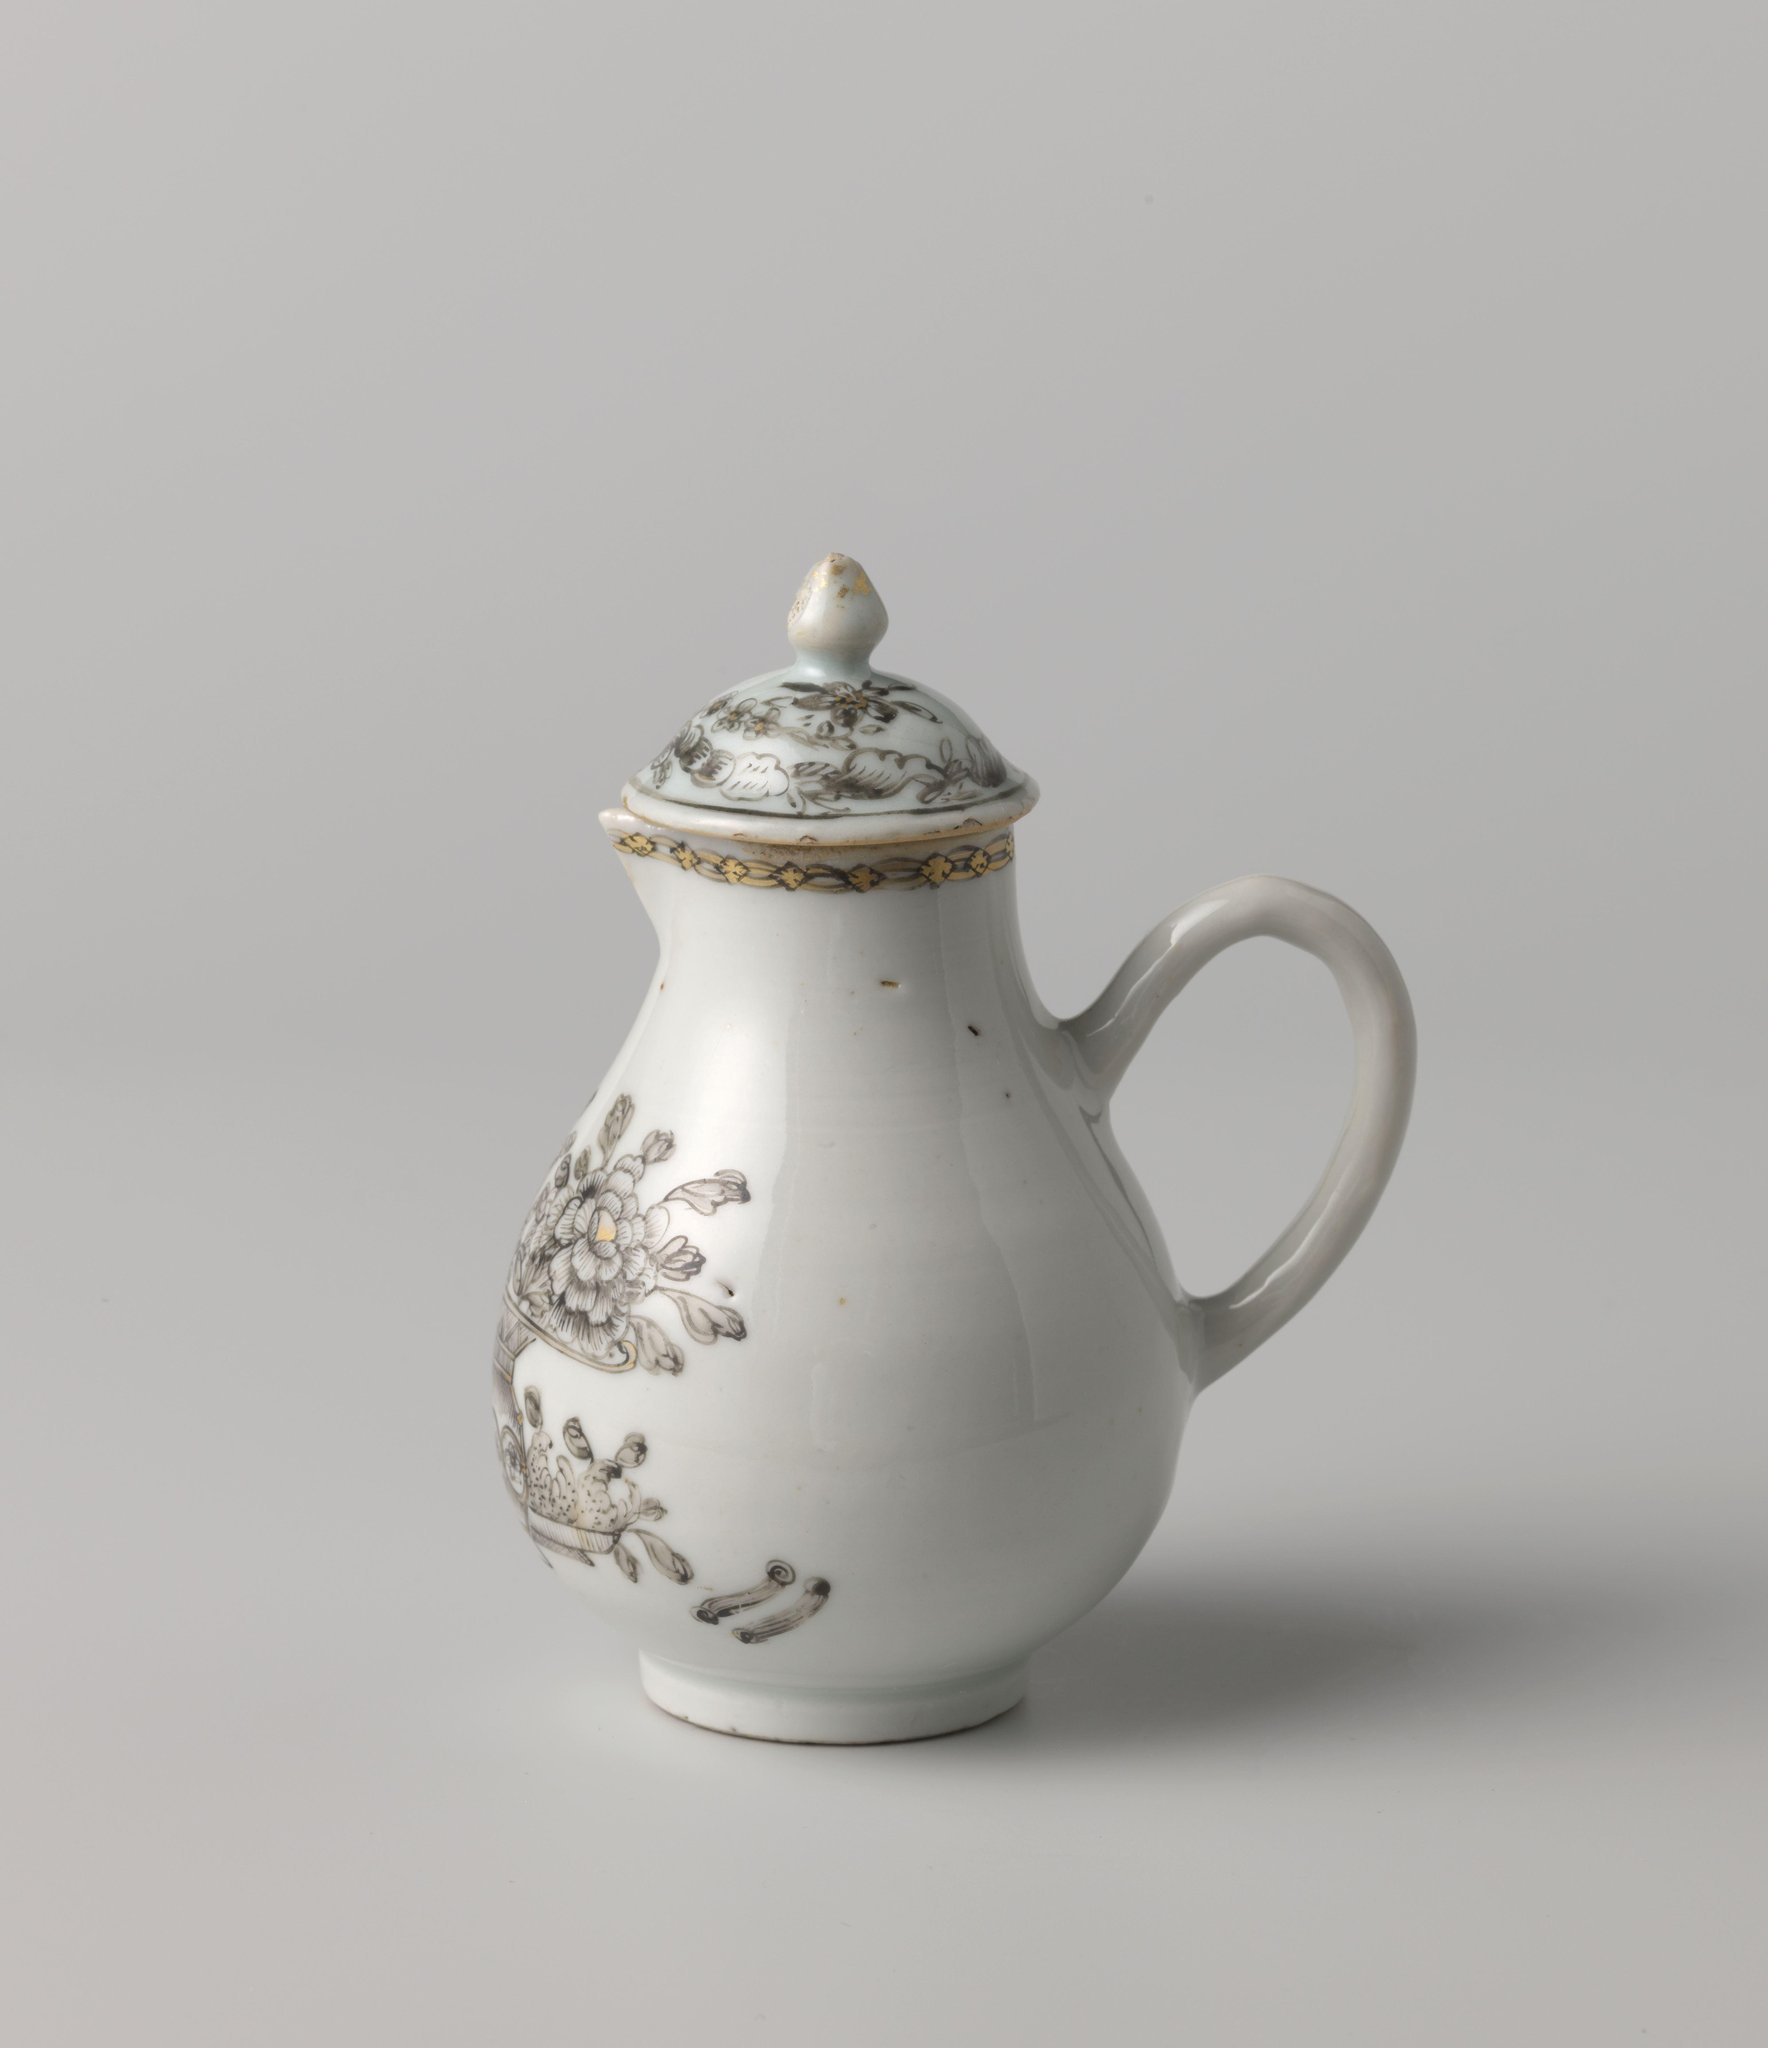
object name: milk jug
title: Pear-shaped milk jug with a flower and fruit basket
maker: Anonymous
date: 1725-1749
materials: glaze, gold, paint, porcelain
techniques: firing, gilding, turning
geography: china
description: Deksel van peervormige melkkan van porselein, beschilderd op het glazuur in zwart en goud. Op de deksel met een band ranken en twee losse bloemen. Deksel niet behorend bij kan. Encre de Chine.